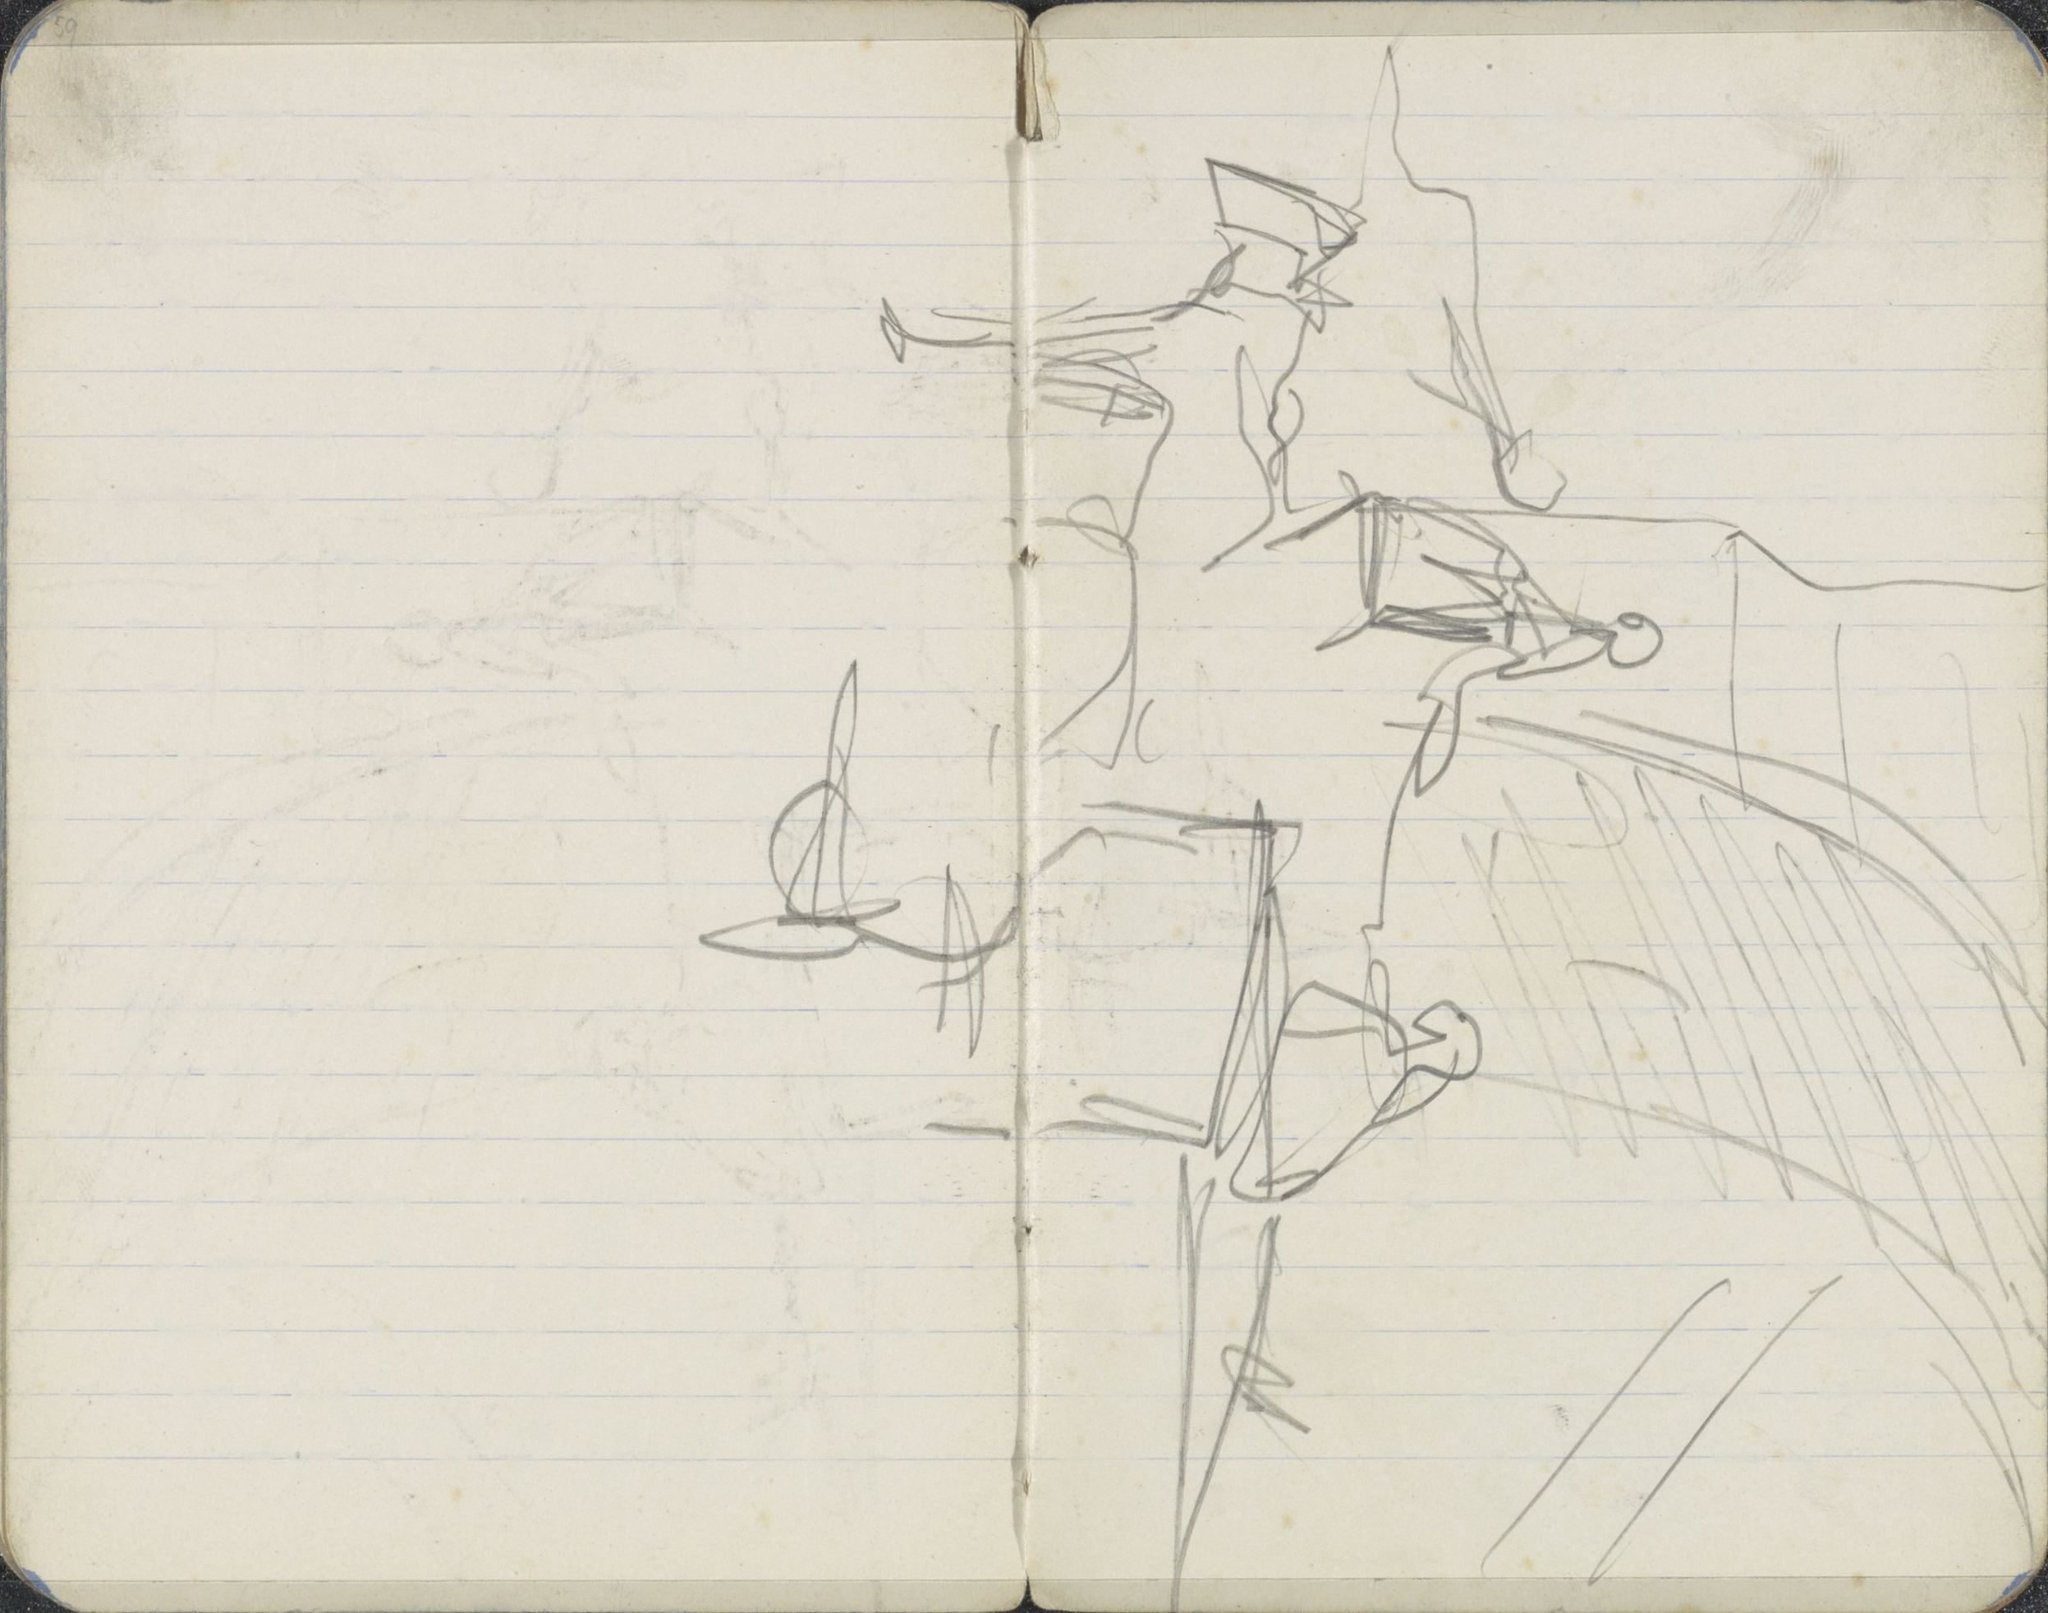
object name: sketchbook leaf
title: Rijtuig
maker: george hendrik breitner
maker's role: draughtsman, painter, print maker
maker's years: 1857-1923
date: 1896-1897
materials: pencil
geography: amsterdam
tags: four-wheeled vehicle drawn by one animal, horse, civic architecture; edifices; dwellings, amsterdam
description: Pagina 59 en pagina 60 uit een schetsboek met 39 bladen.